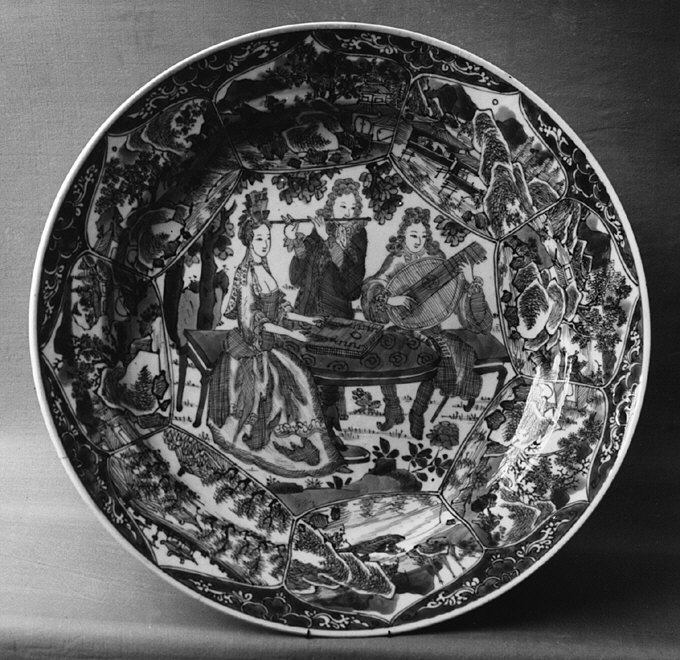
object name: dish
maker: nicolas bonnart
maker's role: artist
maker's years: 1637-1718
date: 1700-1710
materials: porcelain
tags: musical instruments,men,women,music